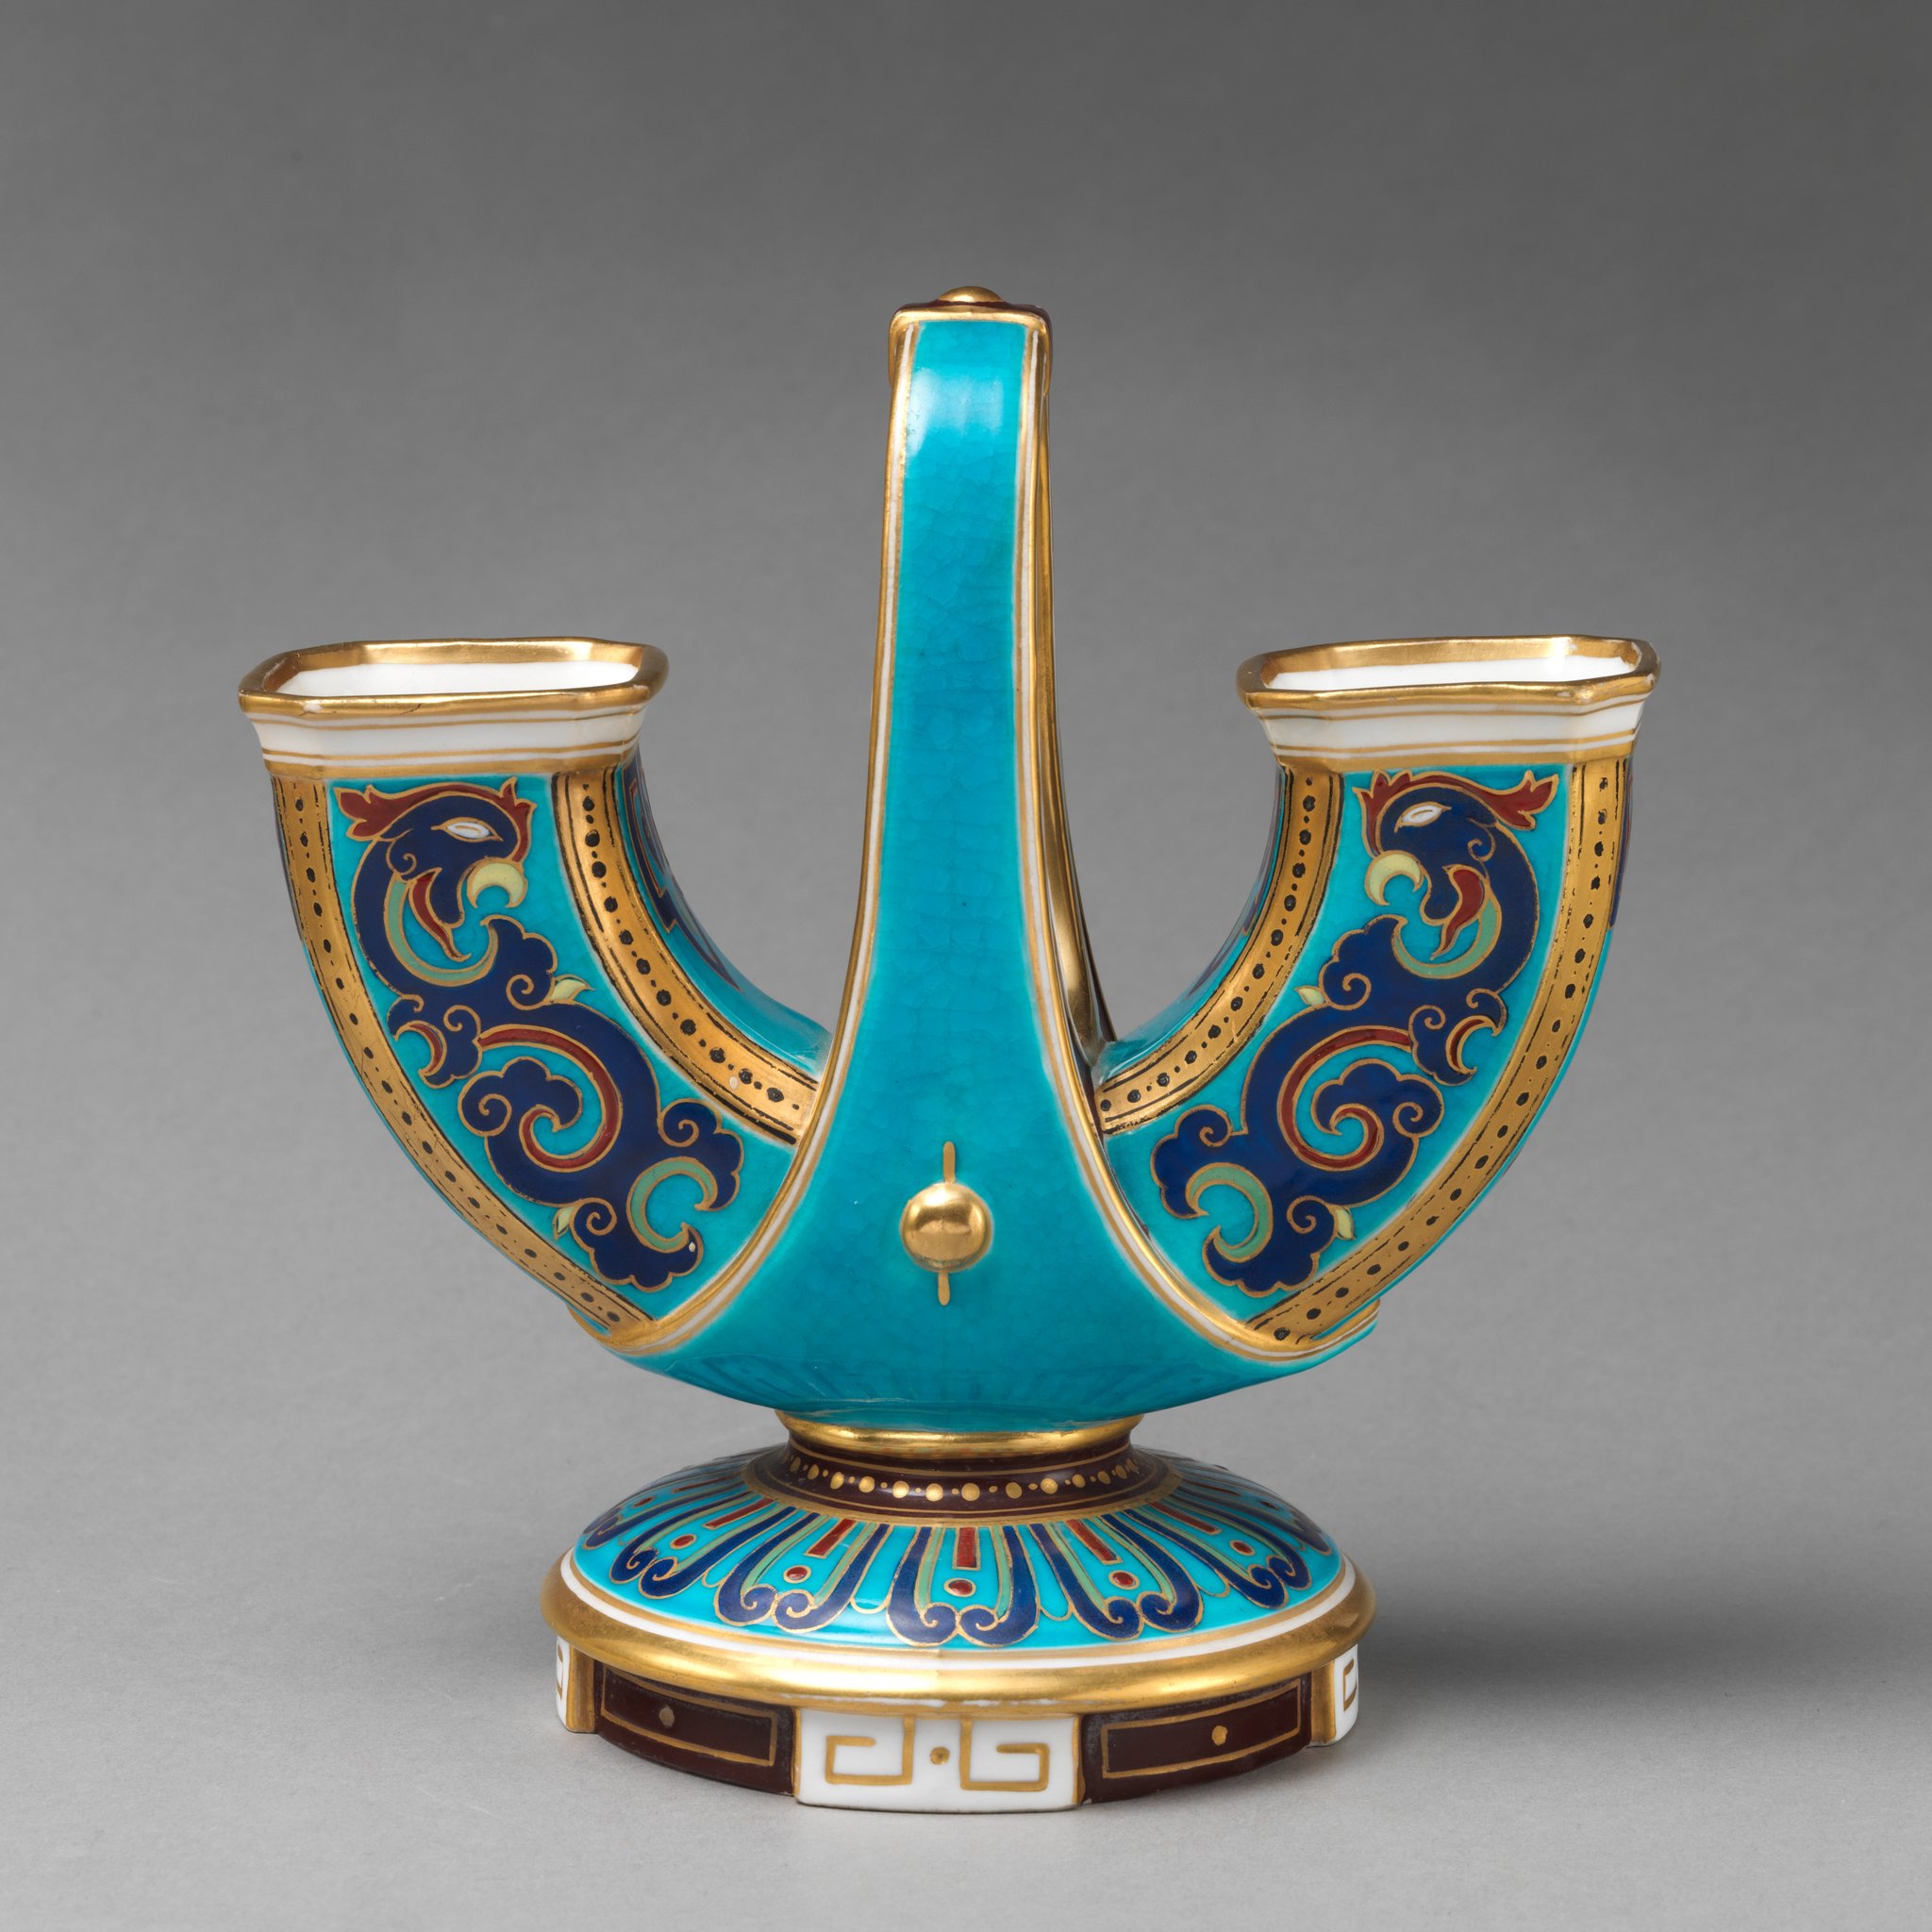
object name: vase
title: U-shaped vase with handle (one of a pair)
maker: minton(s)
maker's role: maker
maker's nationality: british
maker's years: 1793-2001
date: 1869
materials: bone china